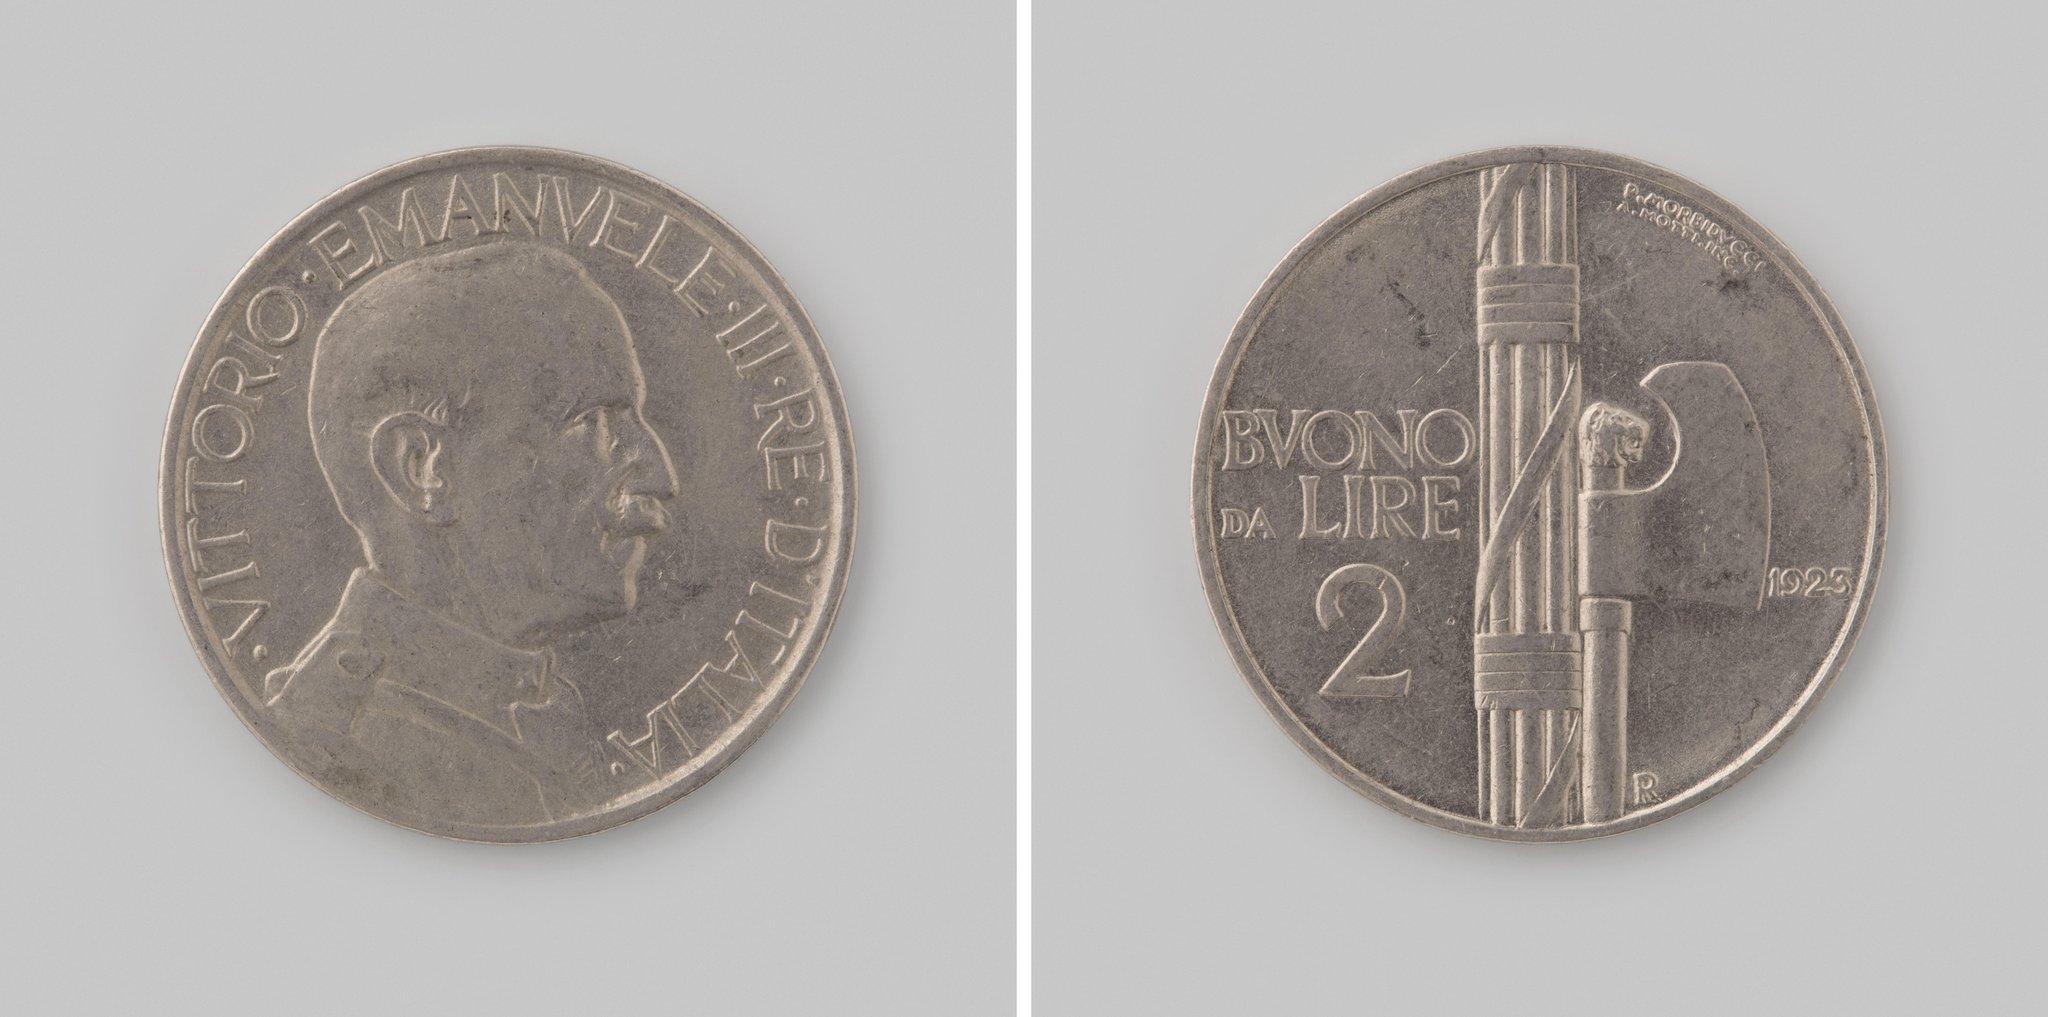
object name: coin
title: Italië, koning Vittorio Emanuele III, 2 lire, 1923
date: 1923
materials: nickel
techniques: striking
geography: rome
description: Nikkelen munt. Voorzijde: portret van de koning naar rechts. Keerzijde: rechtop staande pijlenbundel met bijl. Links daarvan waarde-aanduiding en rechts daarvan jaartal, waaronder muntteken: letter R [=Rome]. Gladde rand.